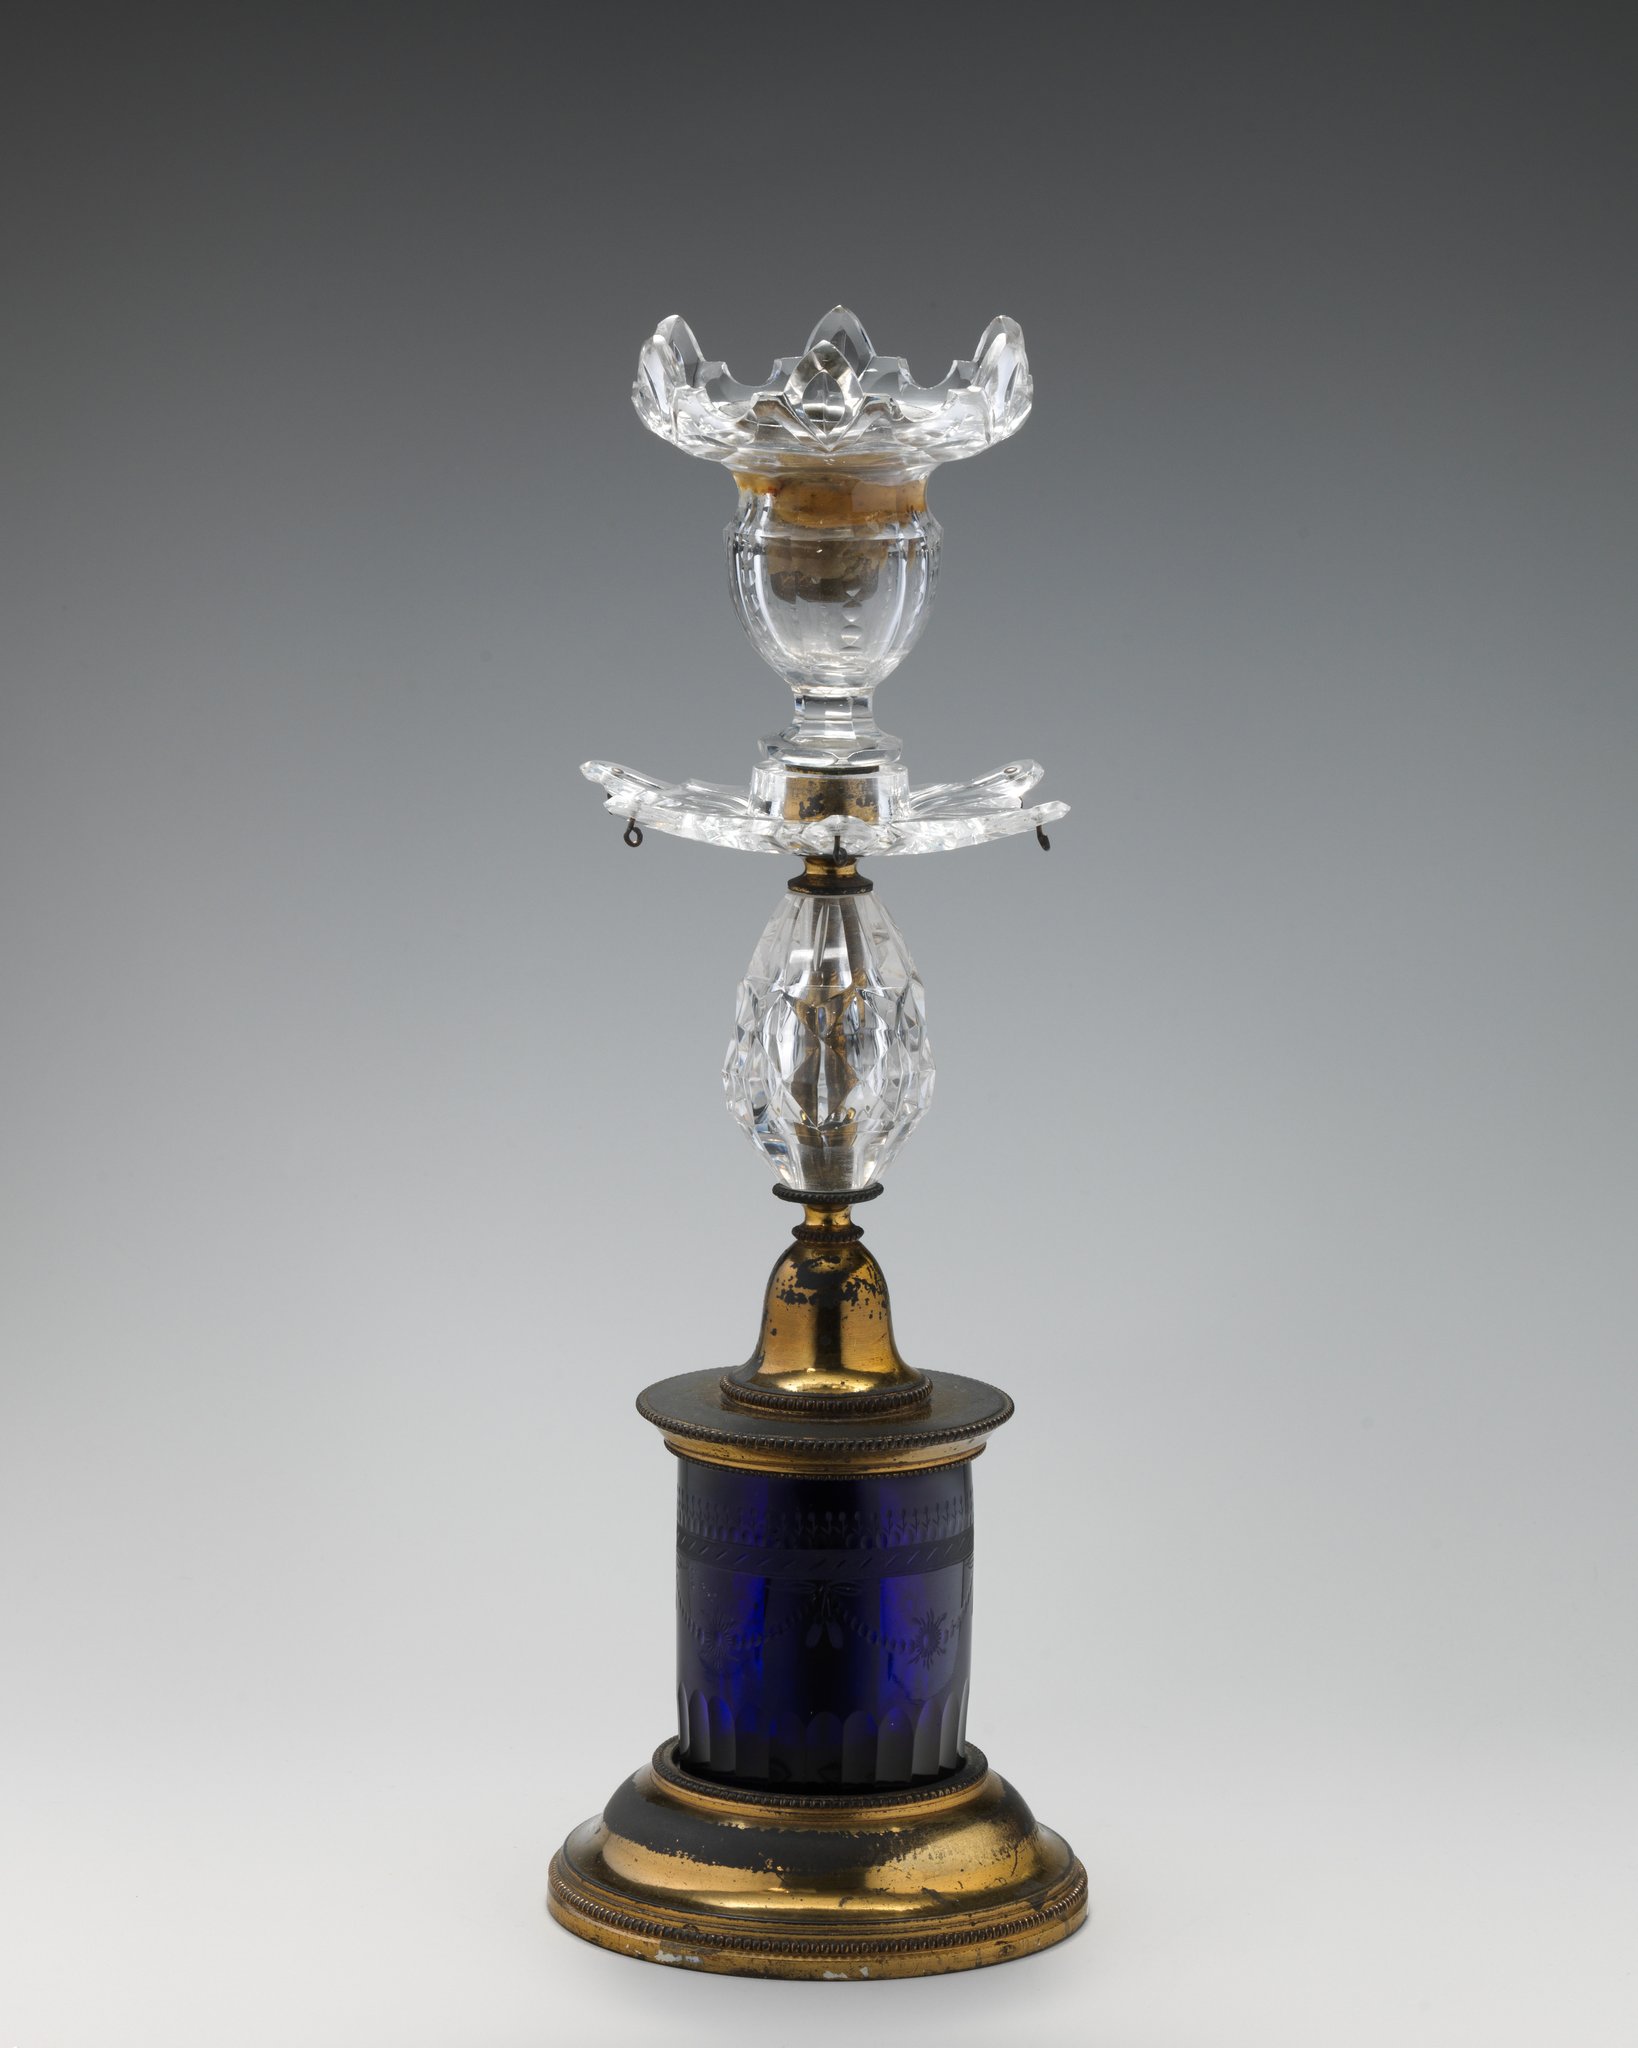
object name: candlestick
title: Candlestick (one of a pair)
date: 1780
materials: gilt bronze, glass